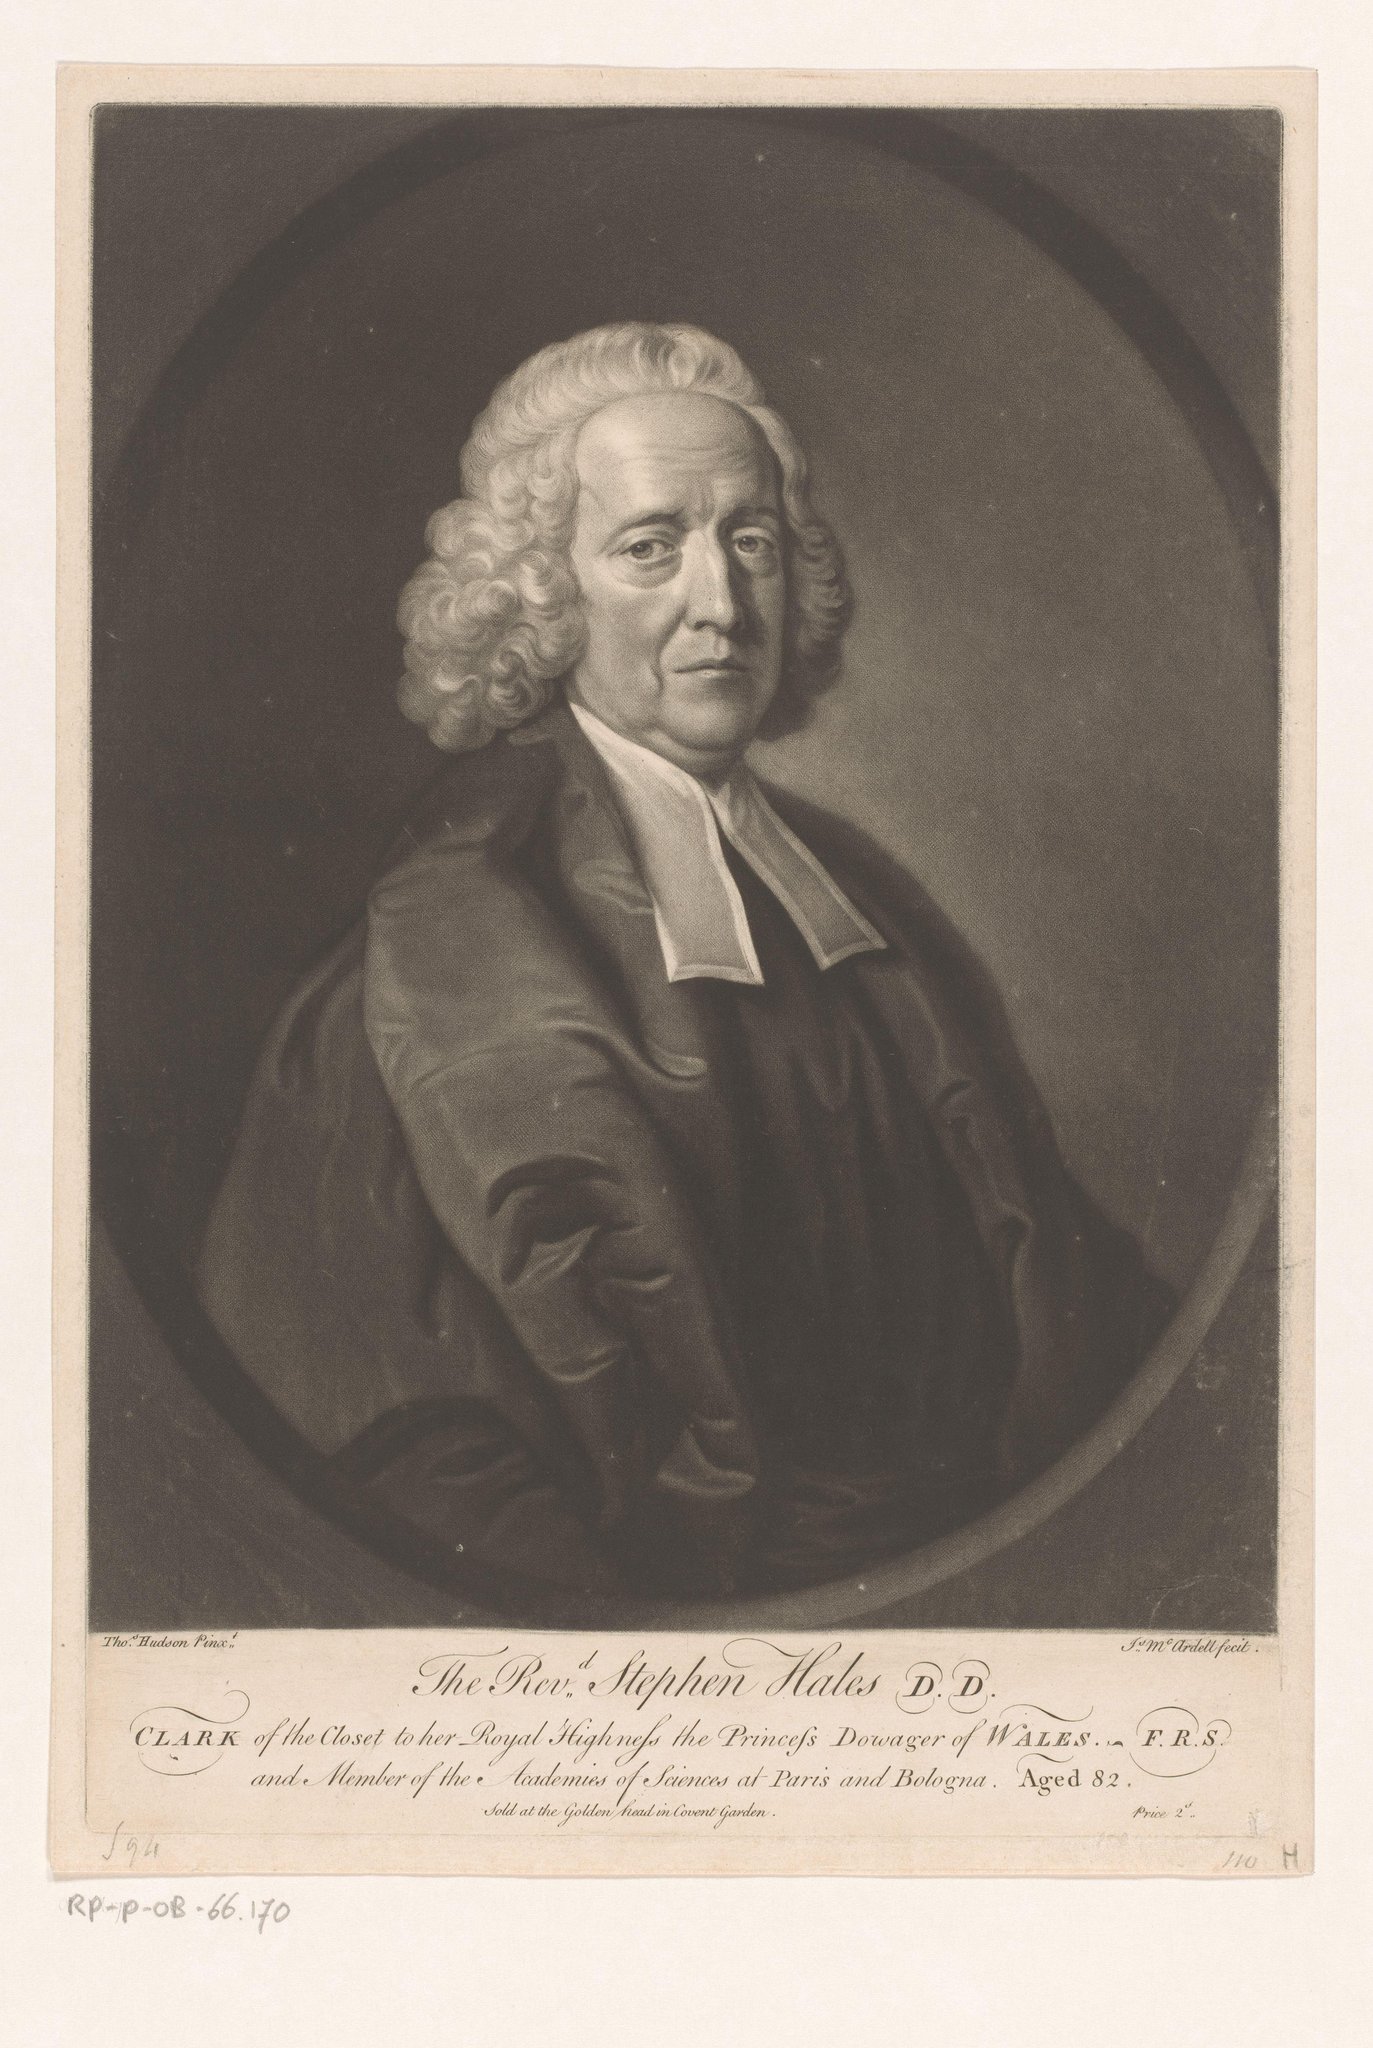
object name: print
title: The Revd. Stephen Hales D.D.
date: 1760-1761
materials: paper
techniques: mezzotint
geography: london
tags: stephen hales, historical persons, science and technology (+ portrait of scholar, scientist)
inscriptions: collector's mark: Lugt 240